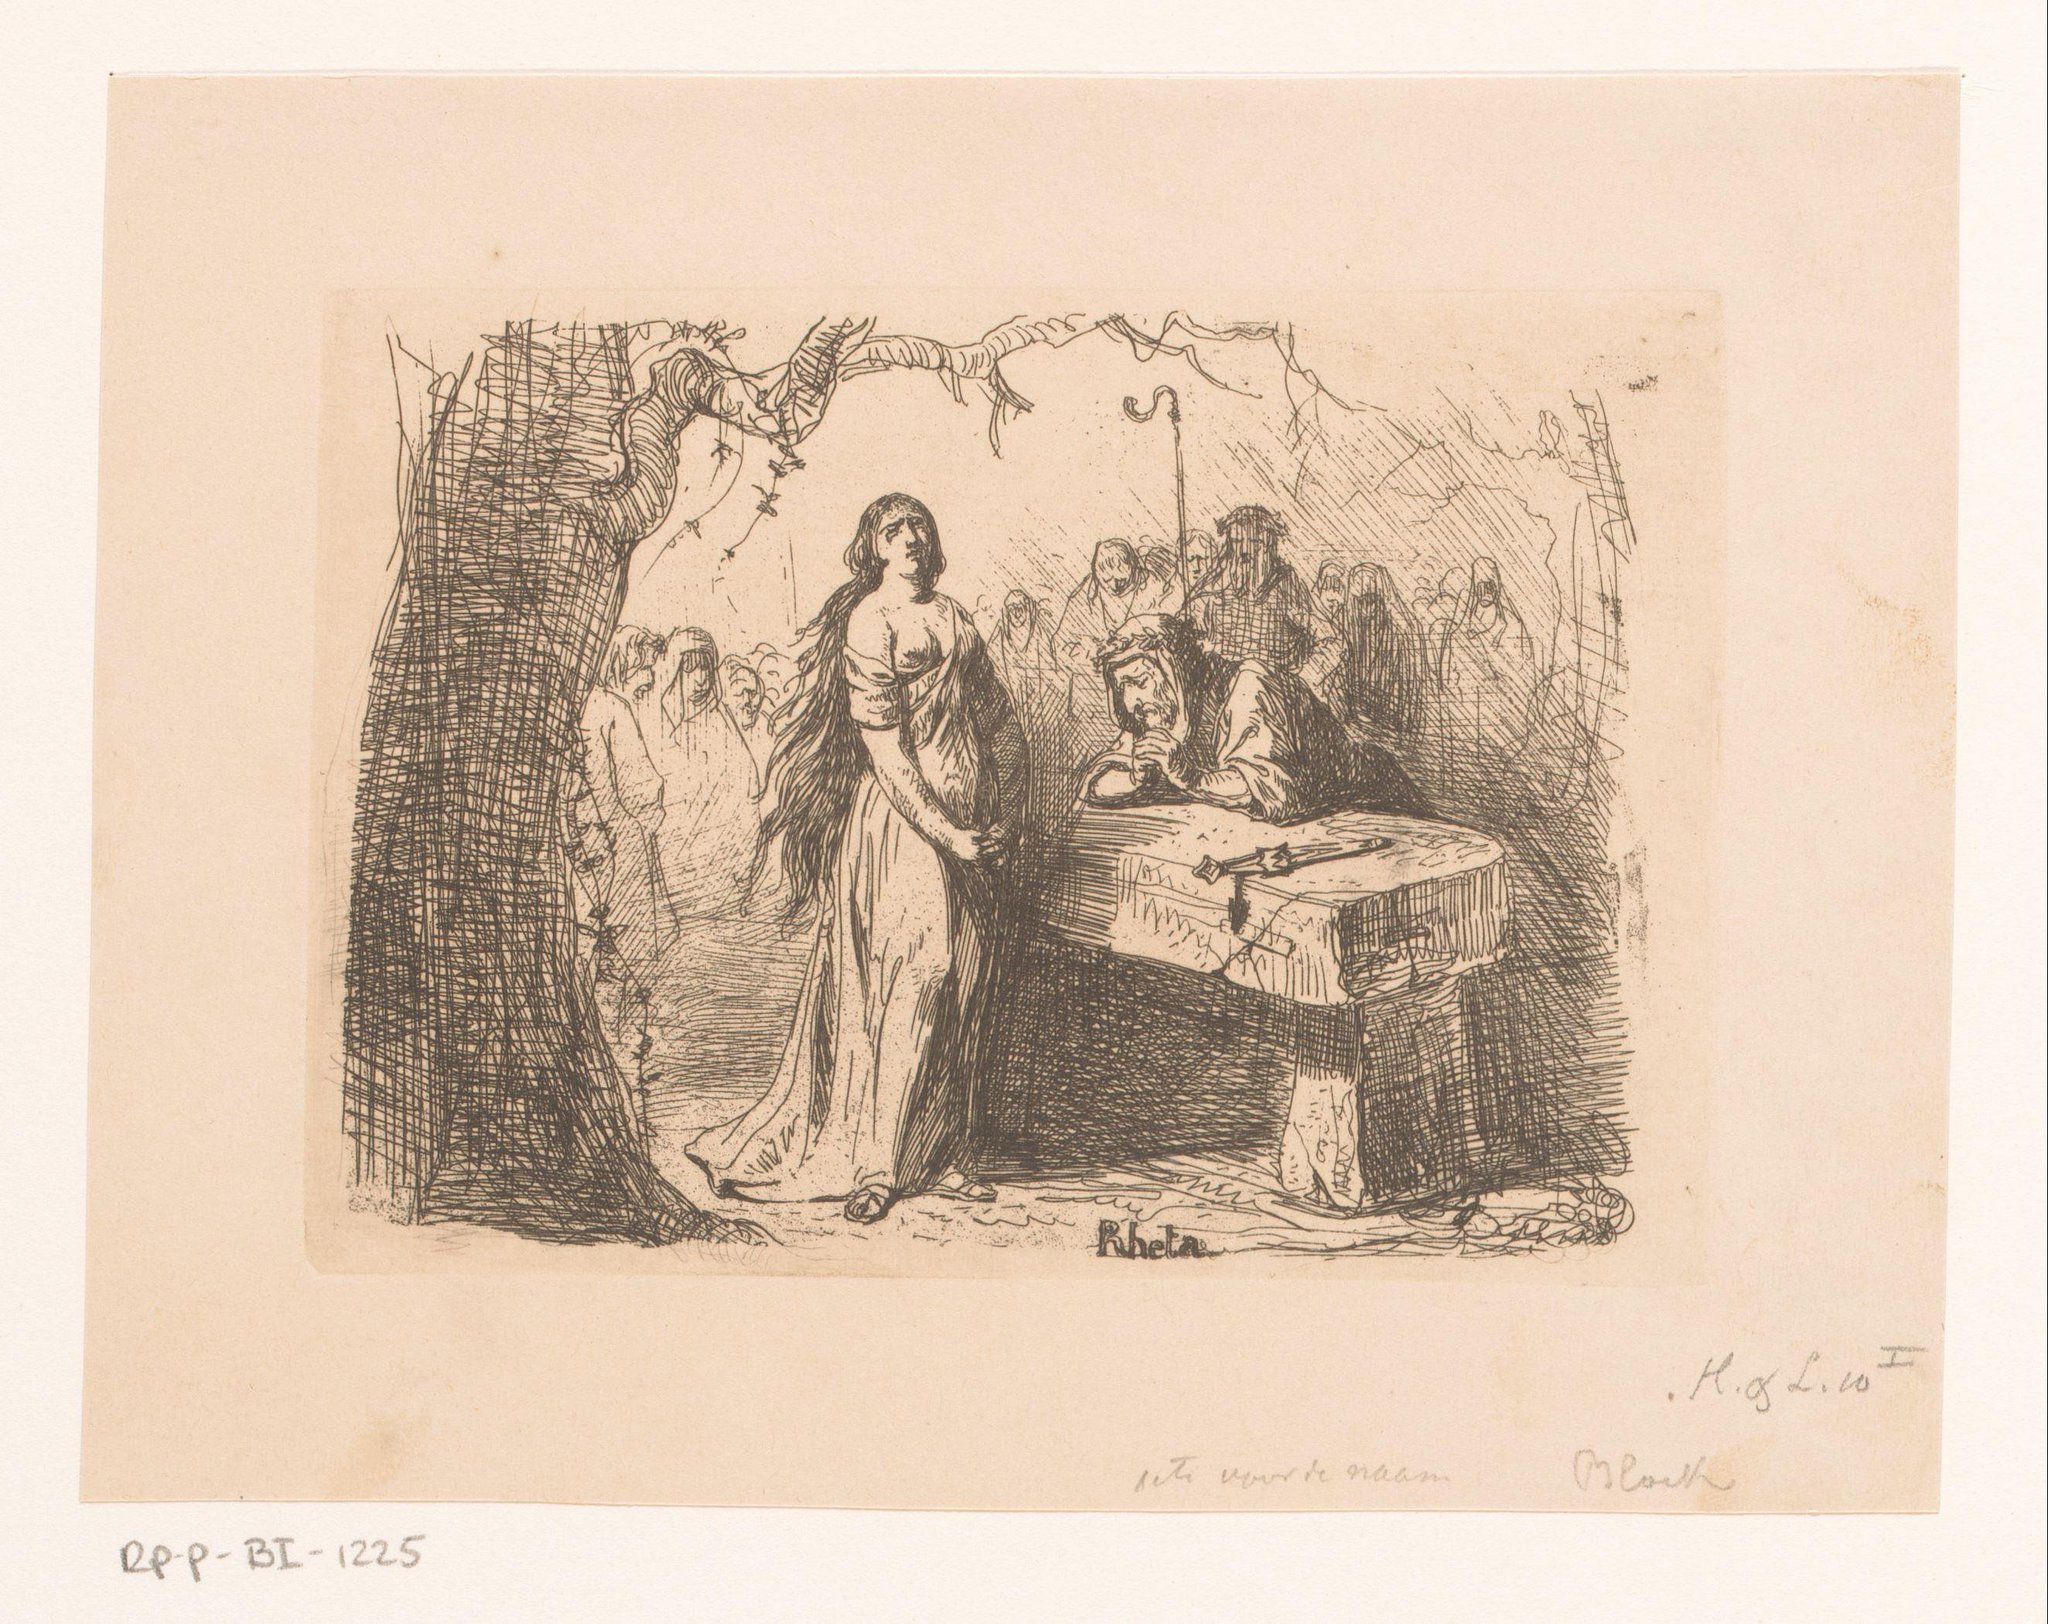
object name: book illustration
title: Rheta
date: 1842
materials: paper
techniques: etching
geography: antwerp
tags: adult woman, human sacrifice ~ non-christian religions, druid (celtic religious functionary)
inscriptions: collector's mark: Lugt 2228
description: Prent uit: Kerckhoven, Pieter Frans van. Oud Belgiën: twee dichtkundige tafereelen uit de Oude geschiedenis des vaderlands. Antwerpen: P. van Bouwel, 1842.